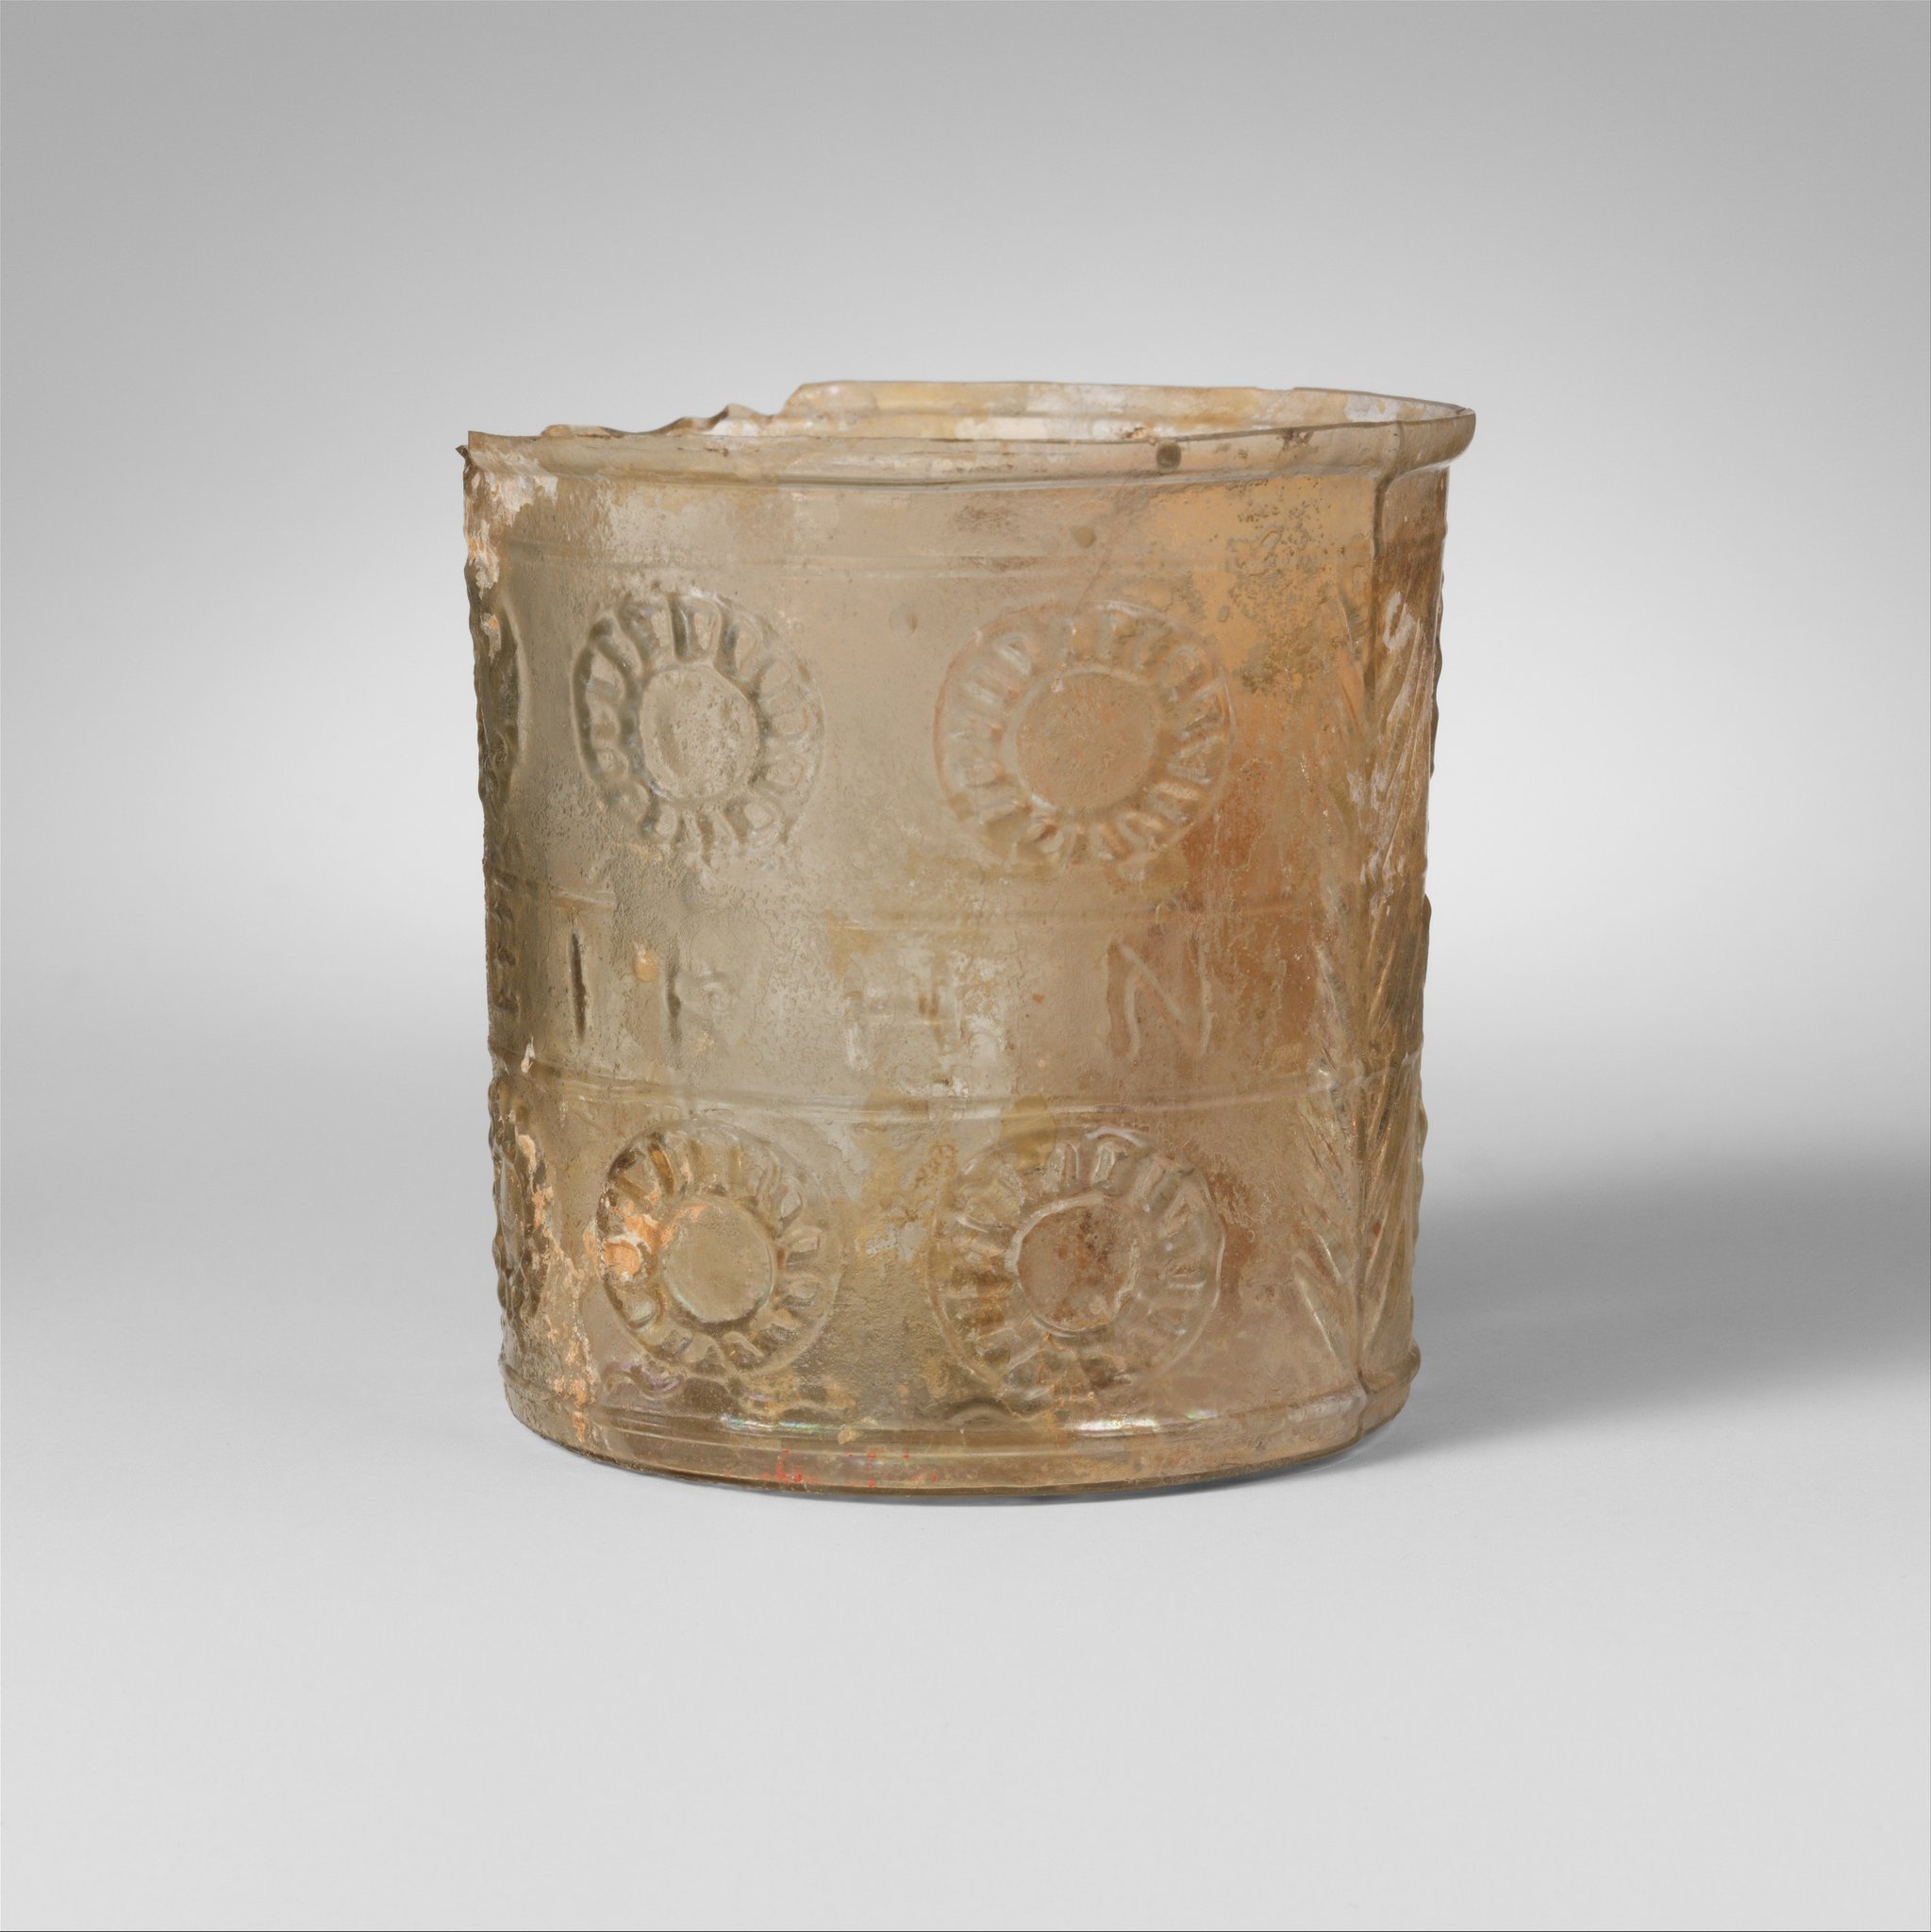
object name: beaker, inscribed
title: Glass beaker with inscription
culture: roman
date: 1-50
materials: glass